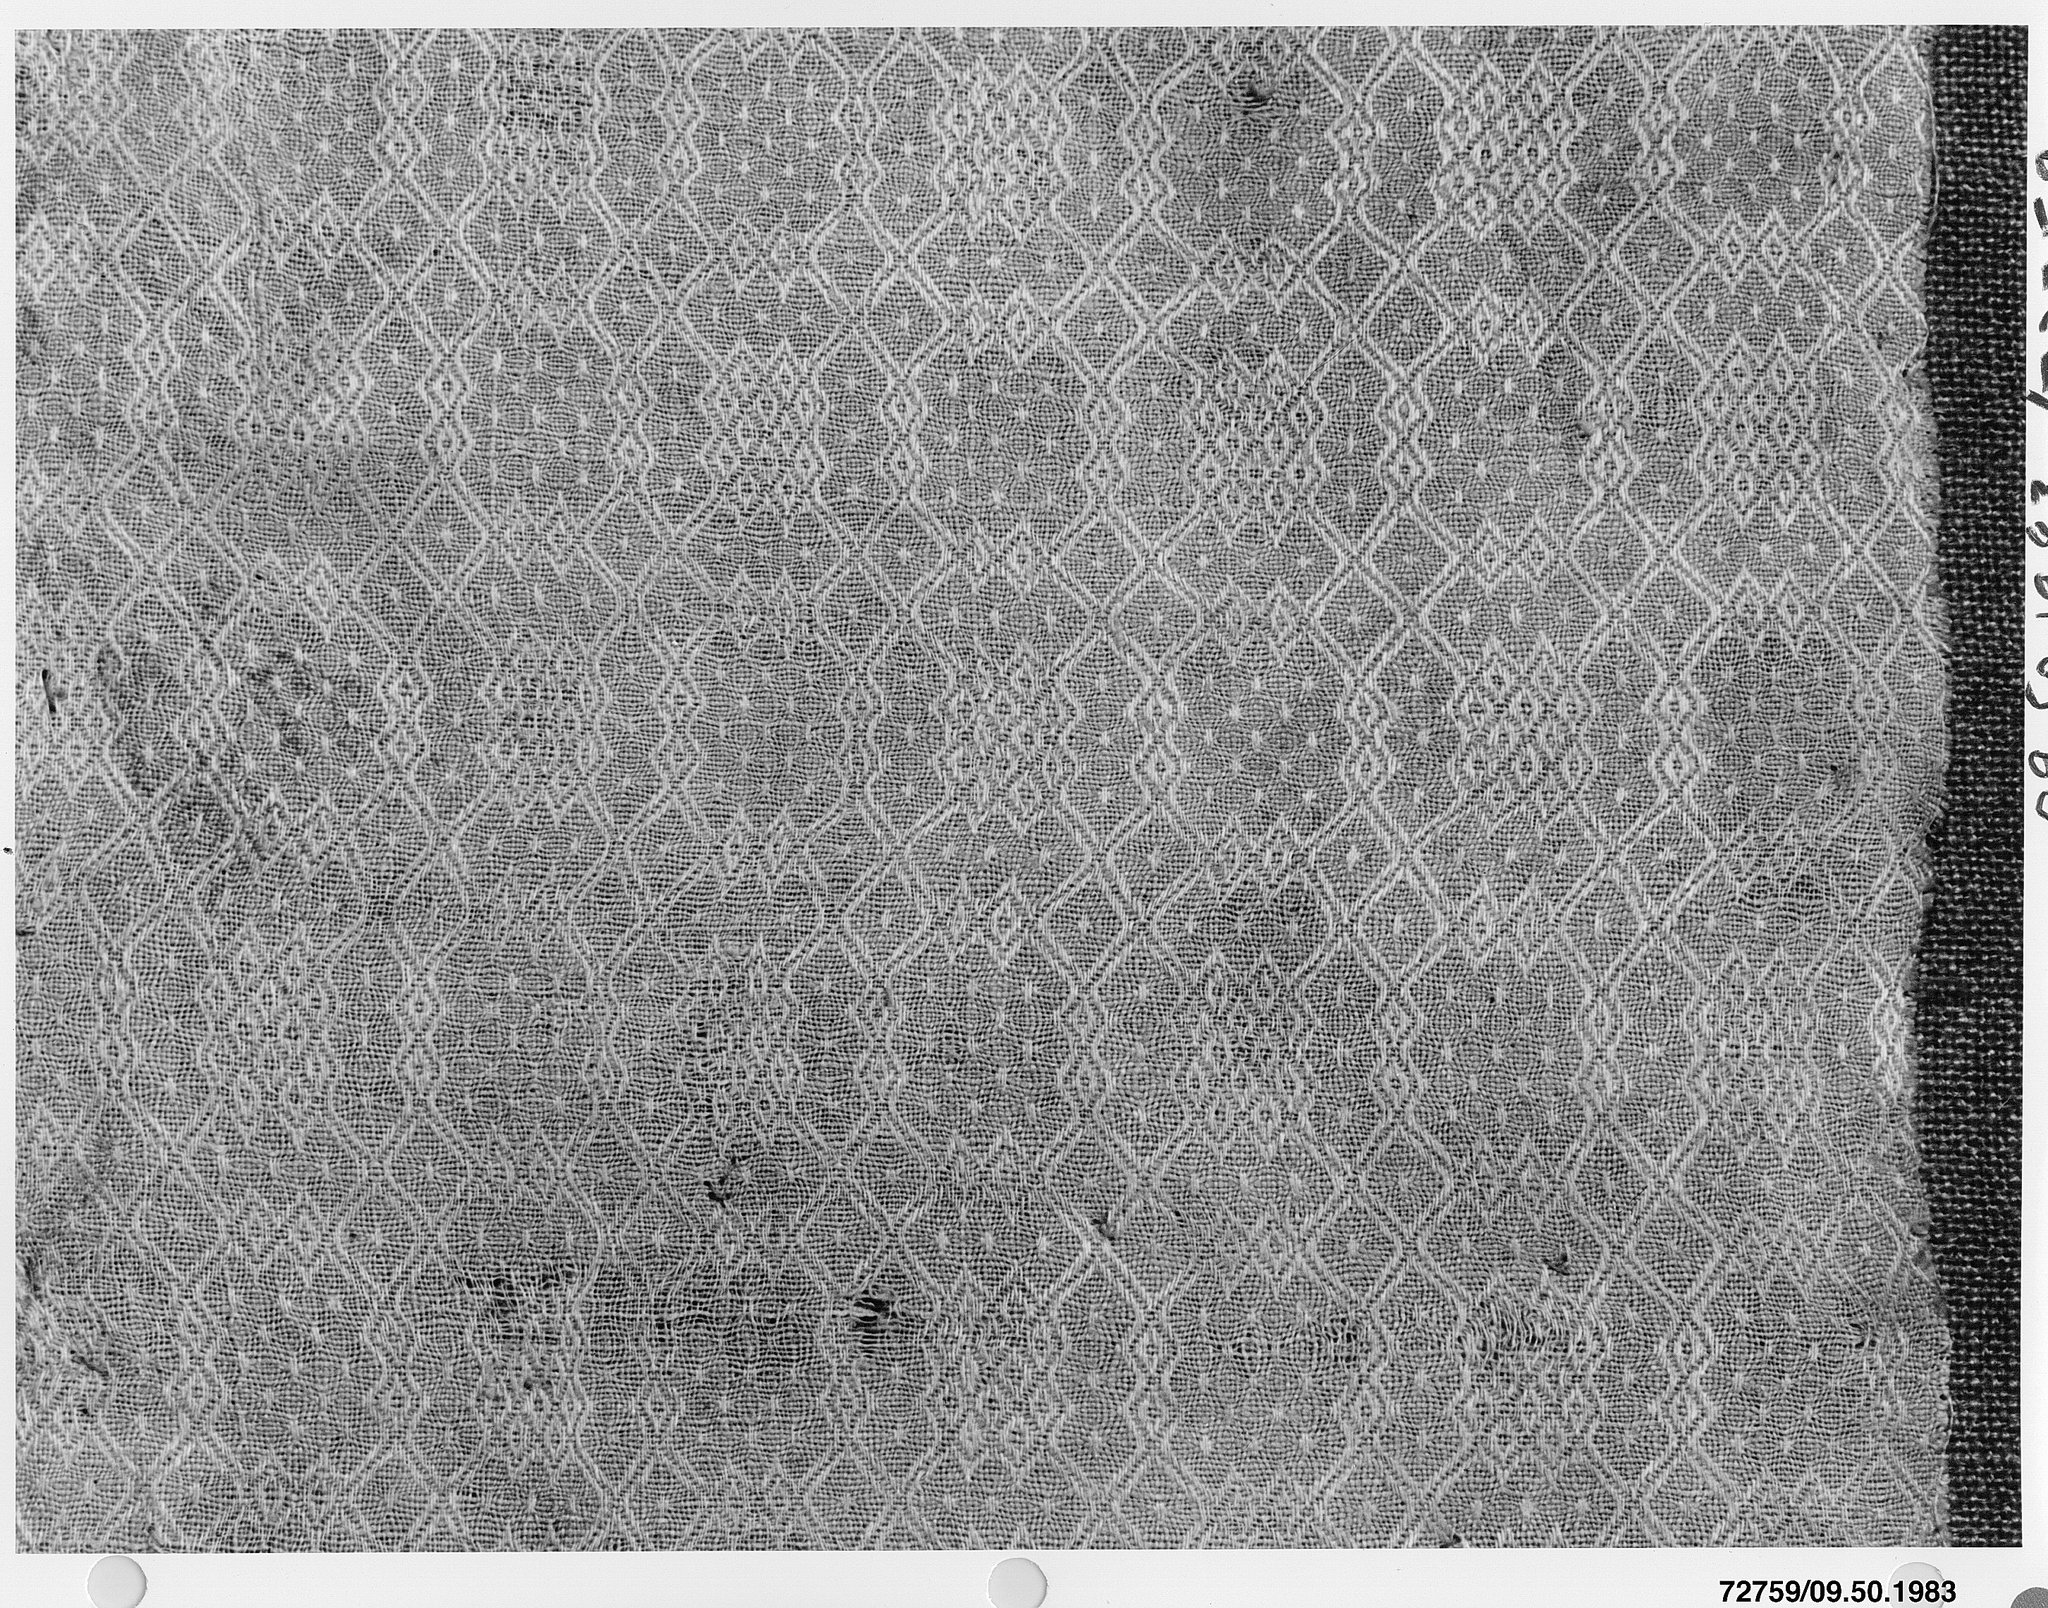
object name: piece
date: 1701-1900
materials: linen